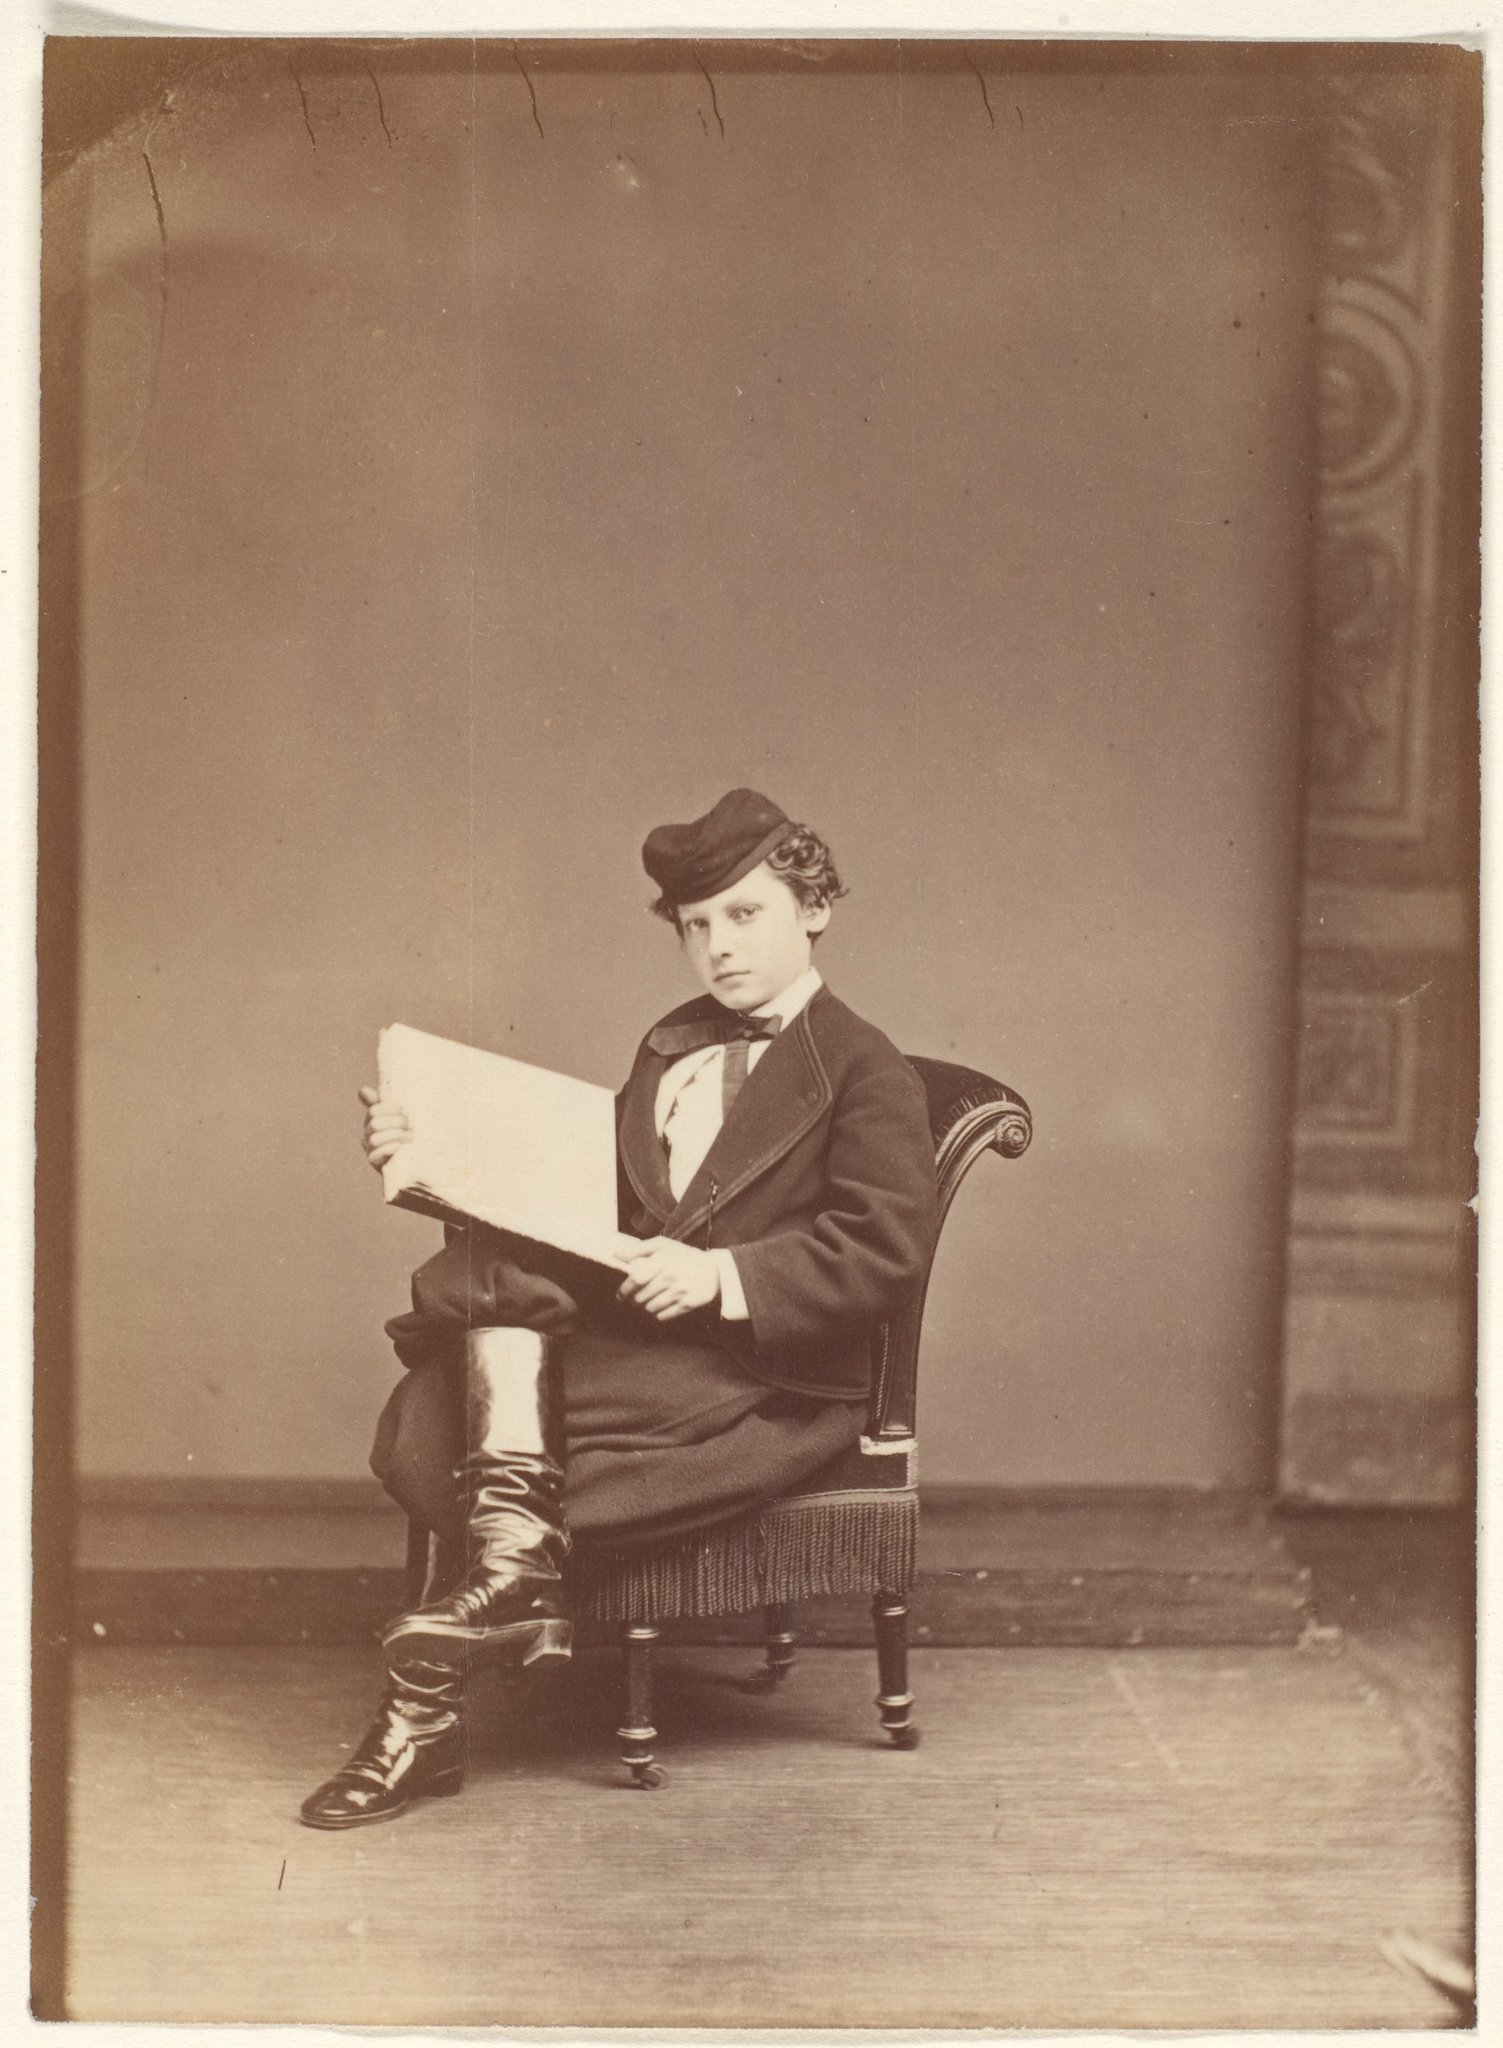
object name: photograph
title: Le petit Russe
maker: pierre-louis pierson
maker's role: artist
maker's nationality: french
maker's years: 1822-1913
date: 1860-1869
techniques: albumen silver print, glass negative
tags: books,boys,portraits